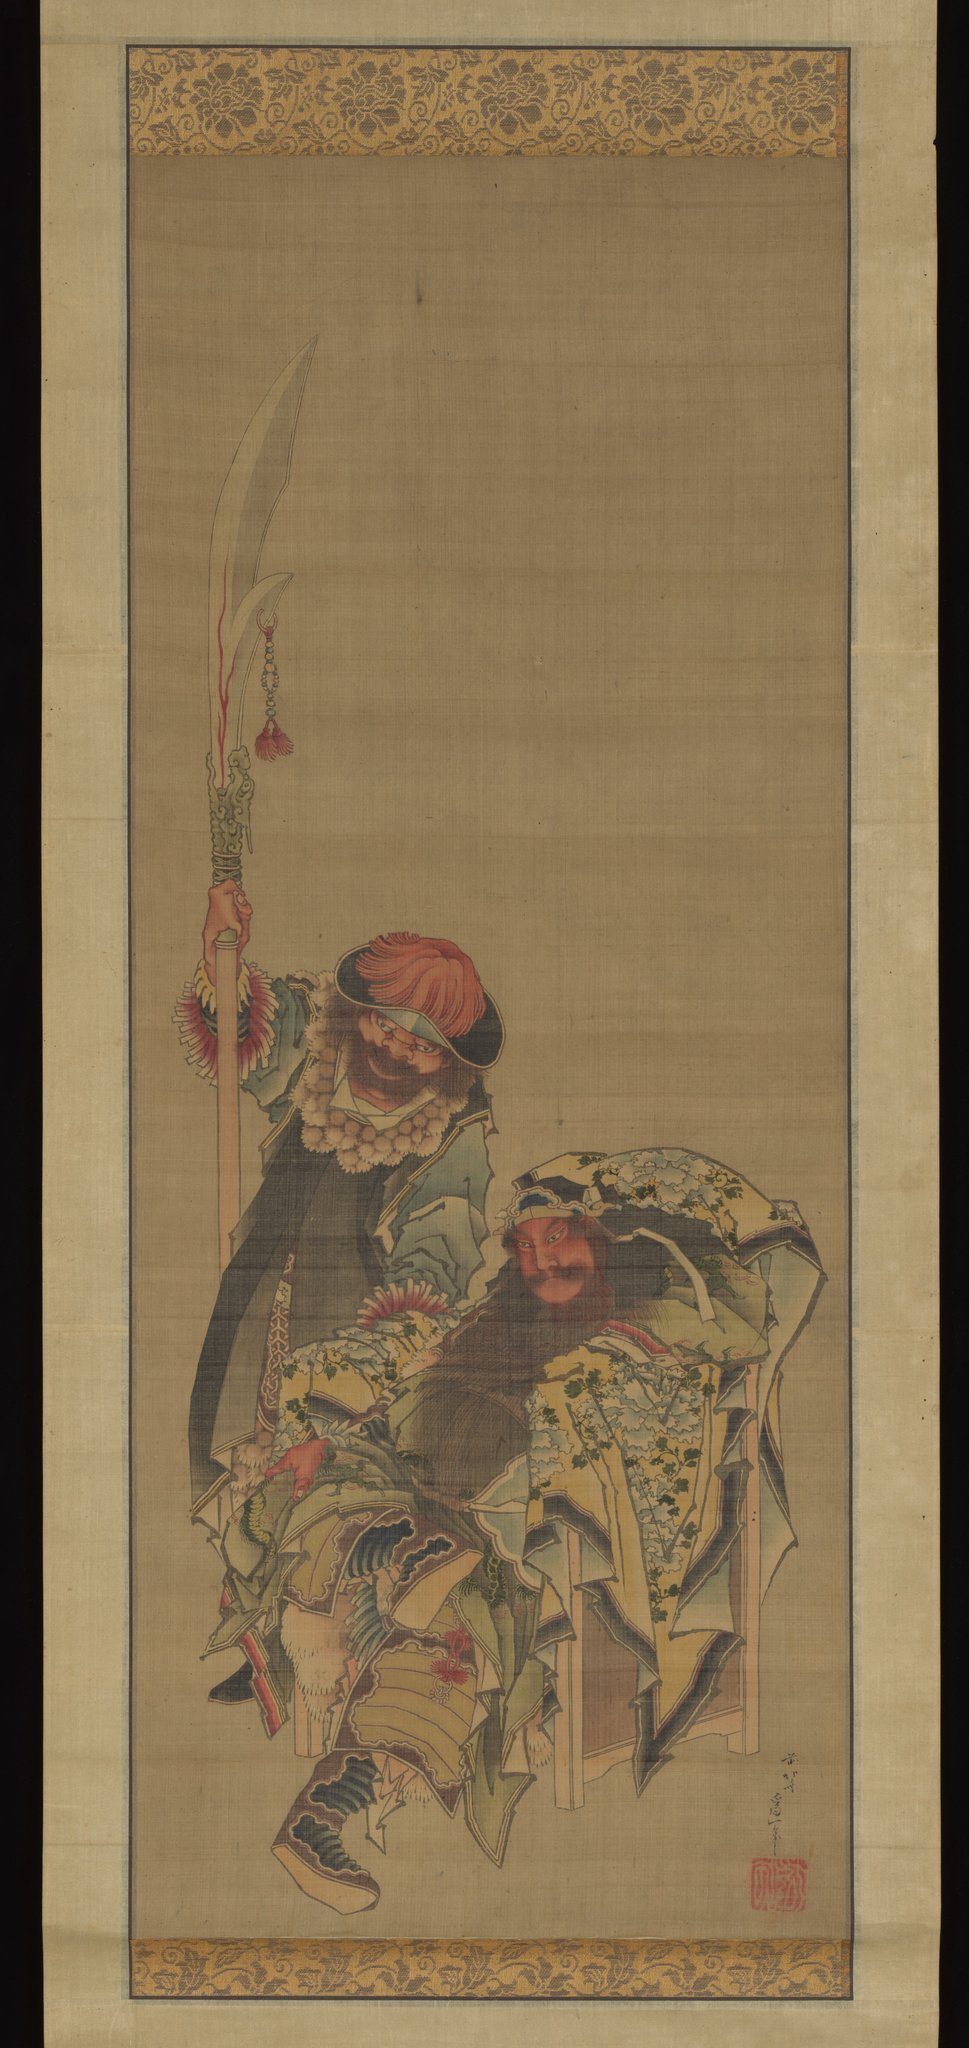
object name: hanging scroll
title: Guan Yu, Chinese God of War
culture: japanese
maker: katsushika hokusai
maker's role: artist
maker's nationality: japanese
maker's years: 1760-1849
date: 1801-1900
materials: ink, silk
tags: men